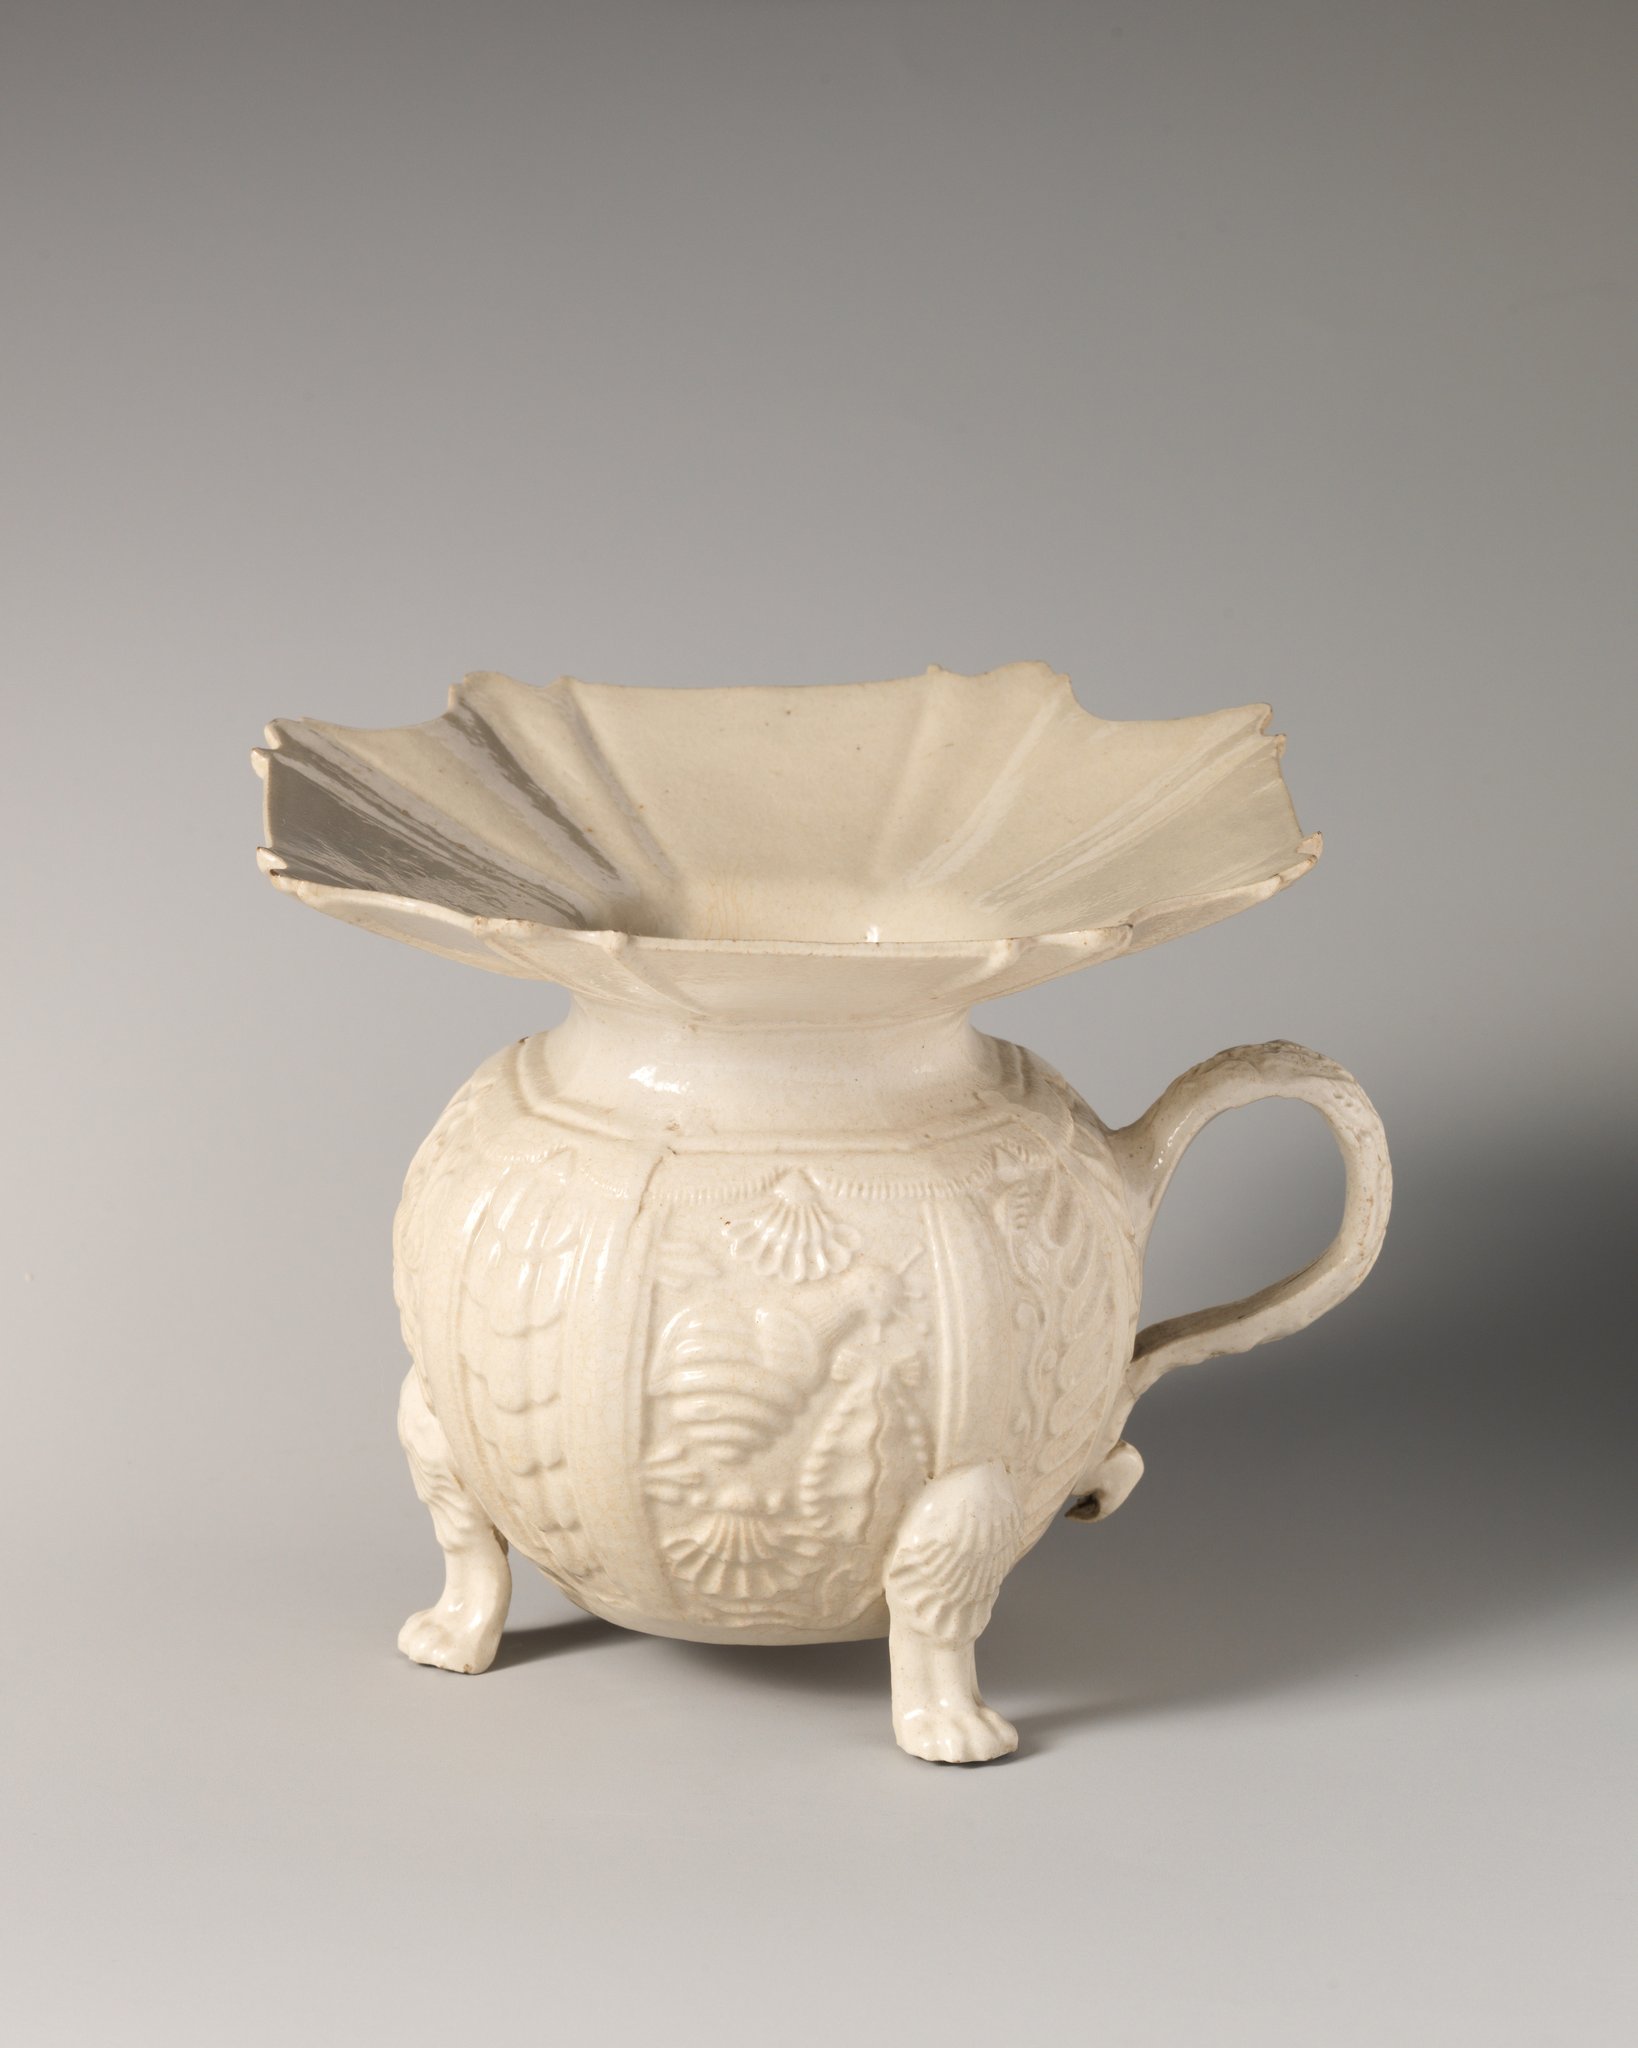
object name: spitoon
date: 1750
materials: stoneware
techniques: salt glaze